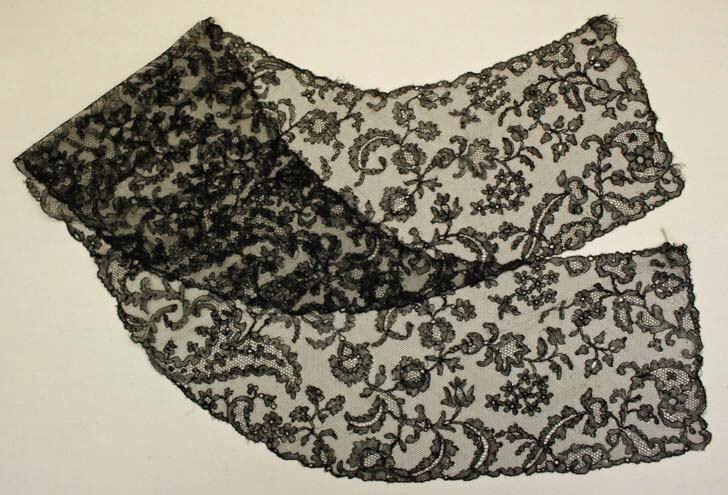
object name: bertha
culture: french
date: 1801-1900